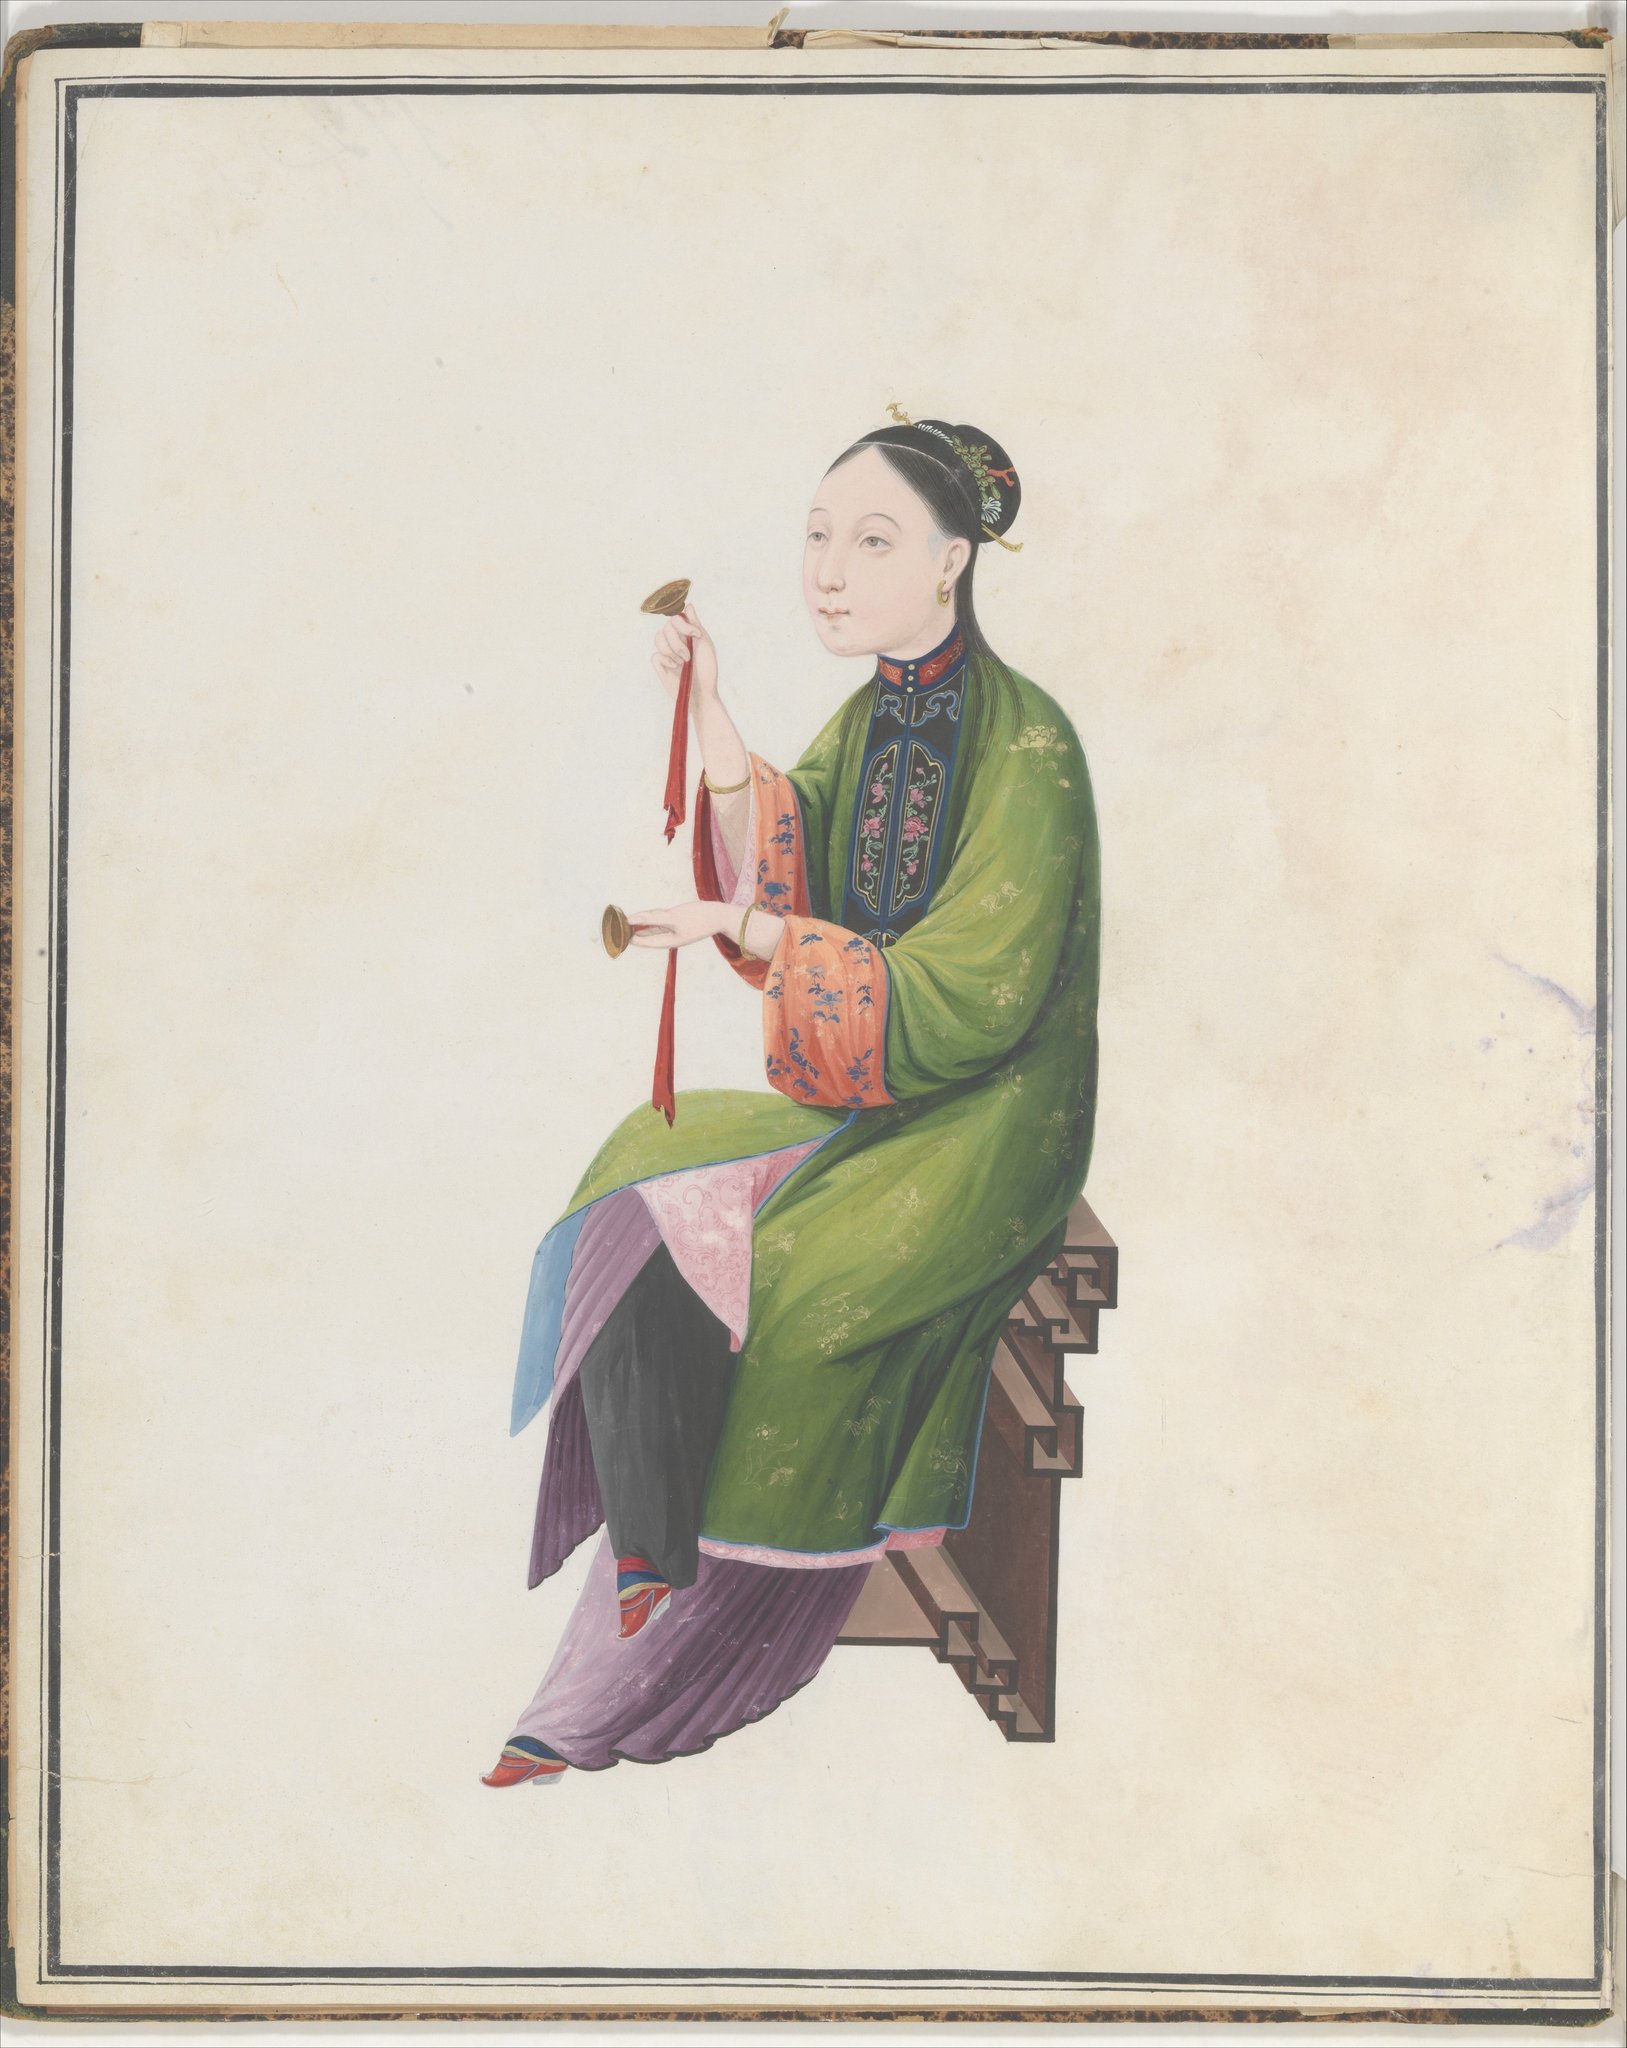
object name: watercolor of musician playing bo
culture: chinese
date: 1767-1800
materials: paper, watercolor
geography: china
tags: musical instruments,women,musicians